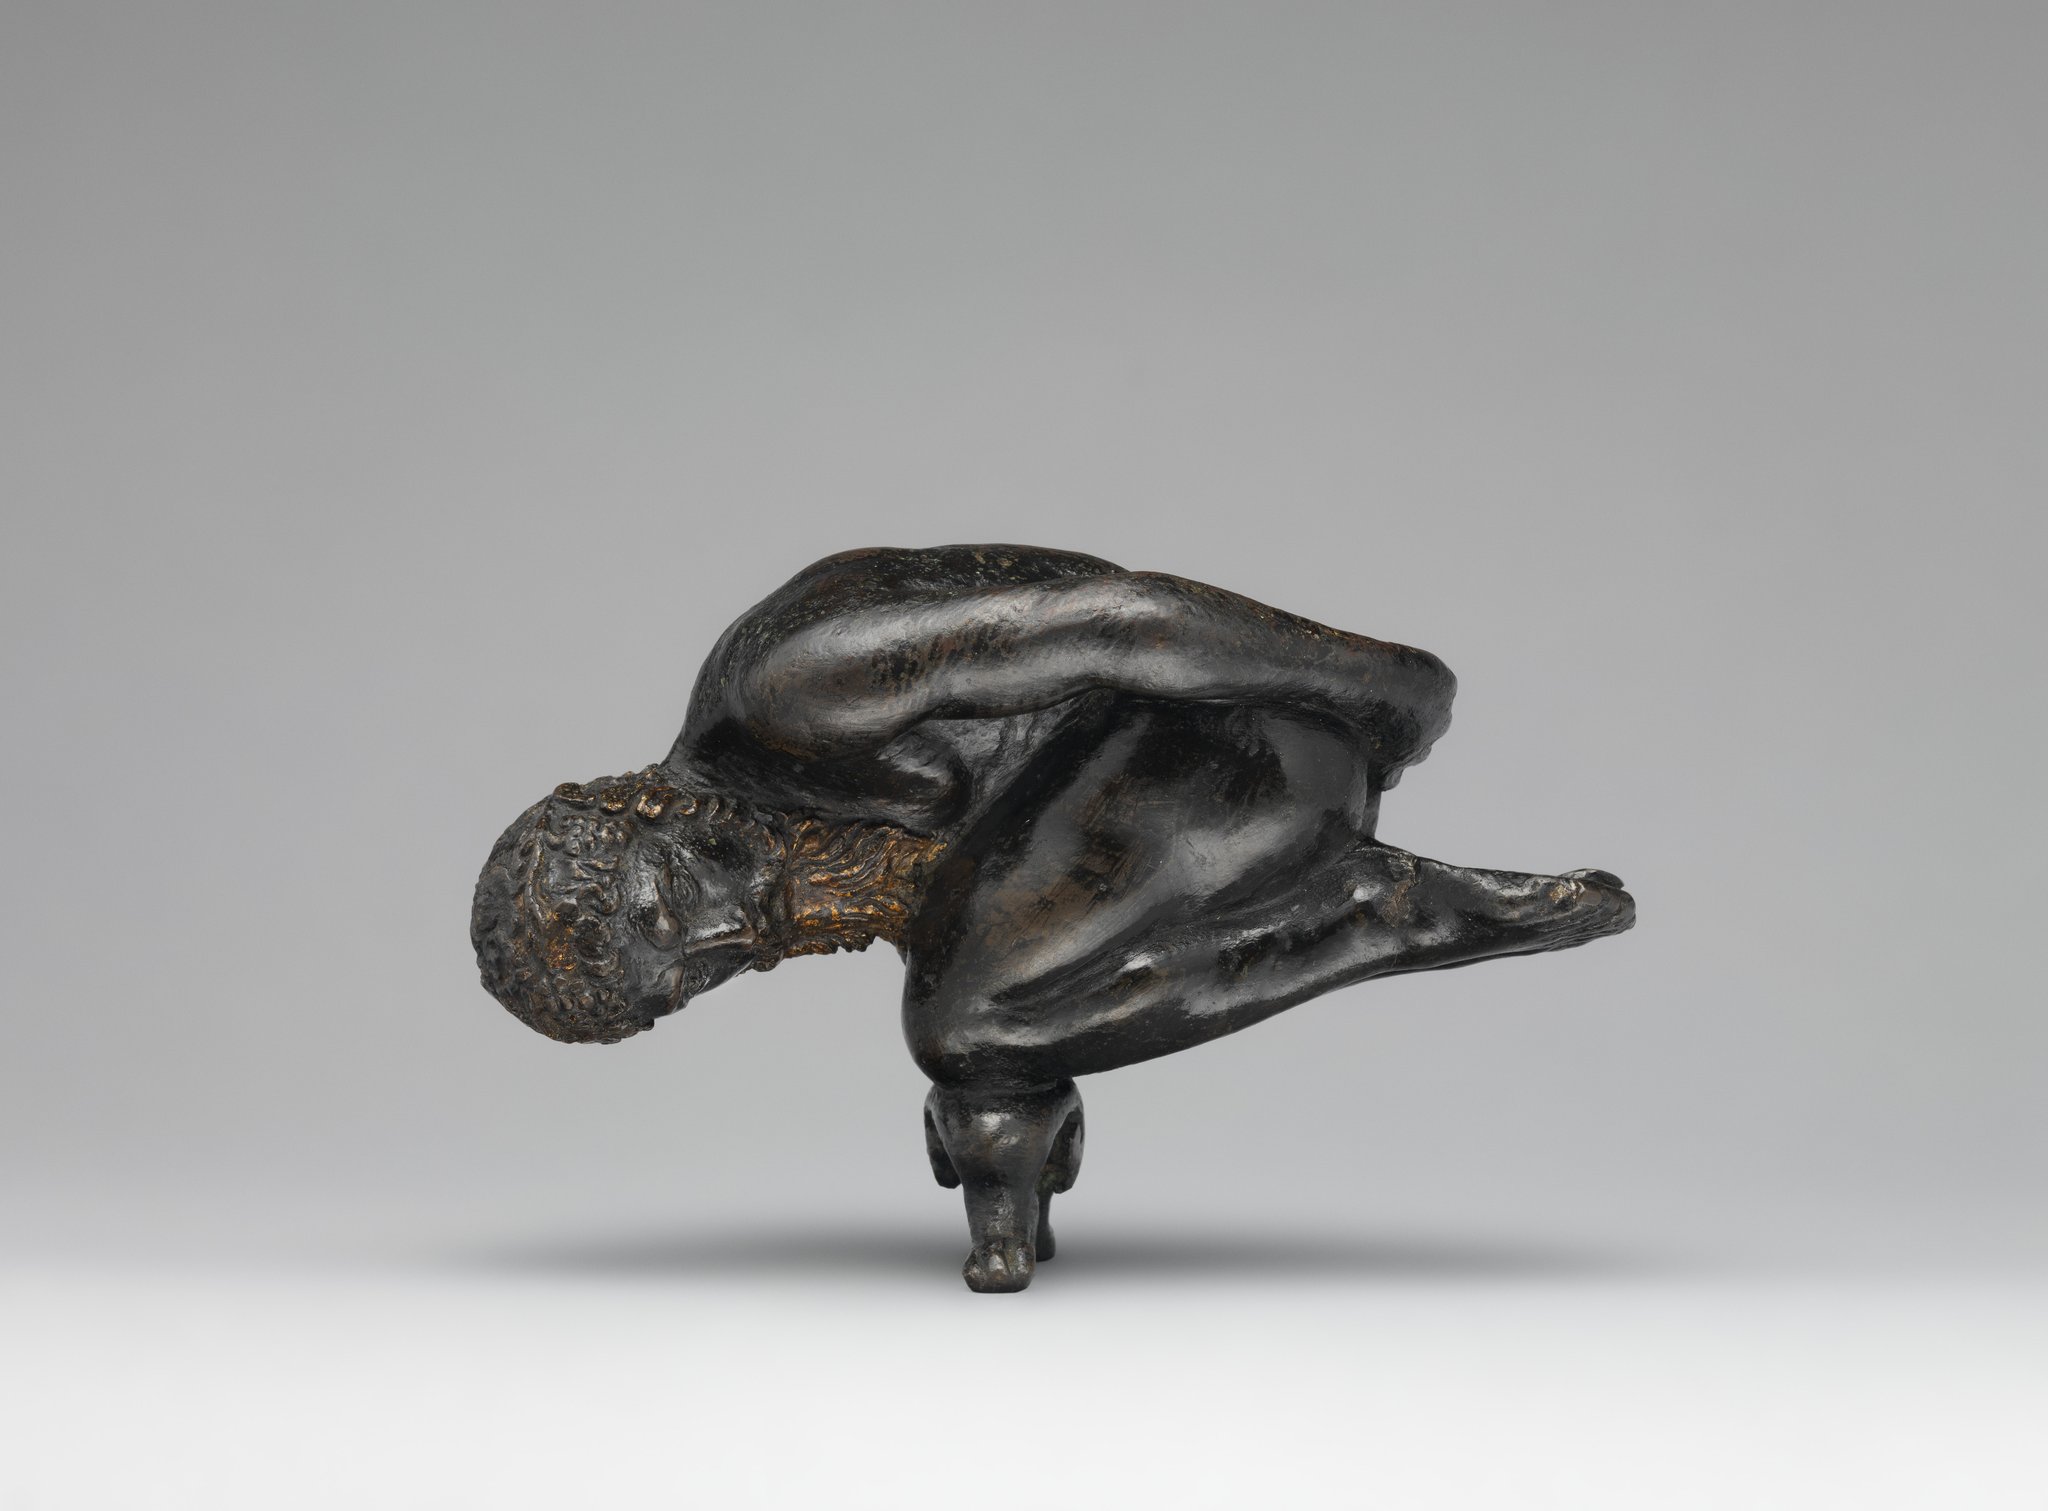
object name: oil lamp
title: Oil lamp in the form of a bearded athlete balanced on his knees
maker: agostino zoppo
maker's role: artist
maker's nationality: italian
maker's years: 1515-1572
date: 1520-1530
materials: bronze, gilt, oil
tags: men,acrobats